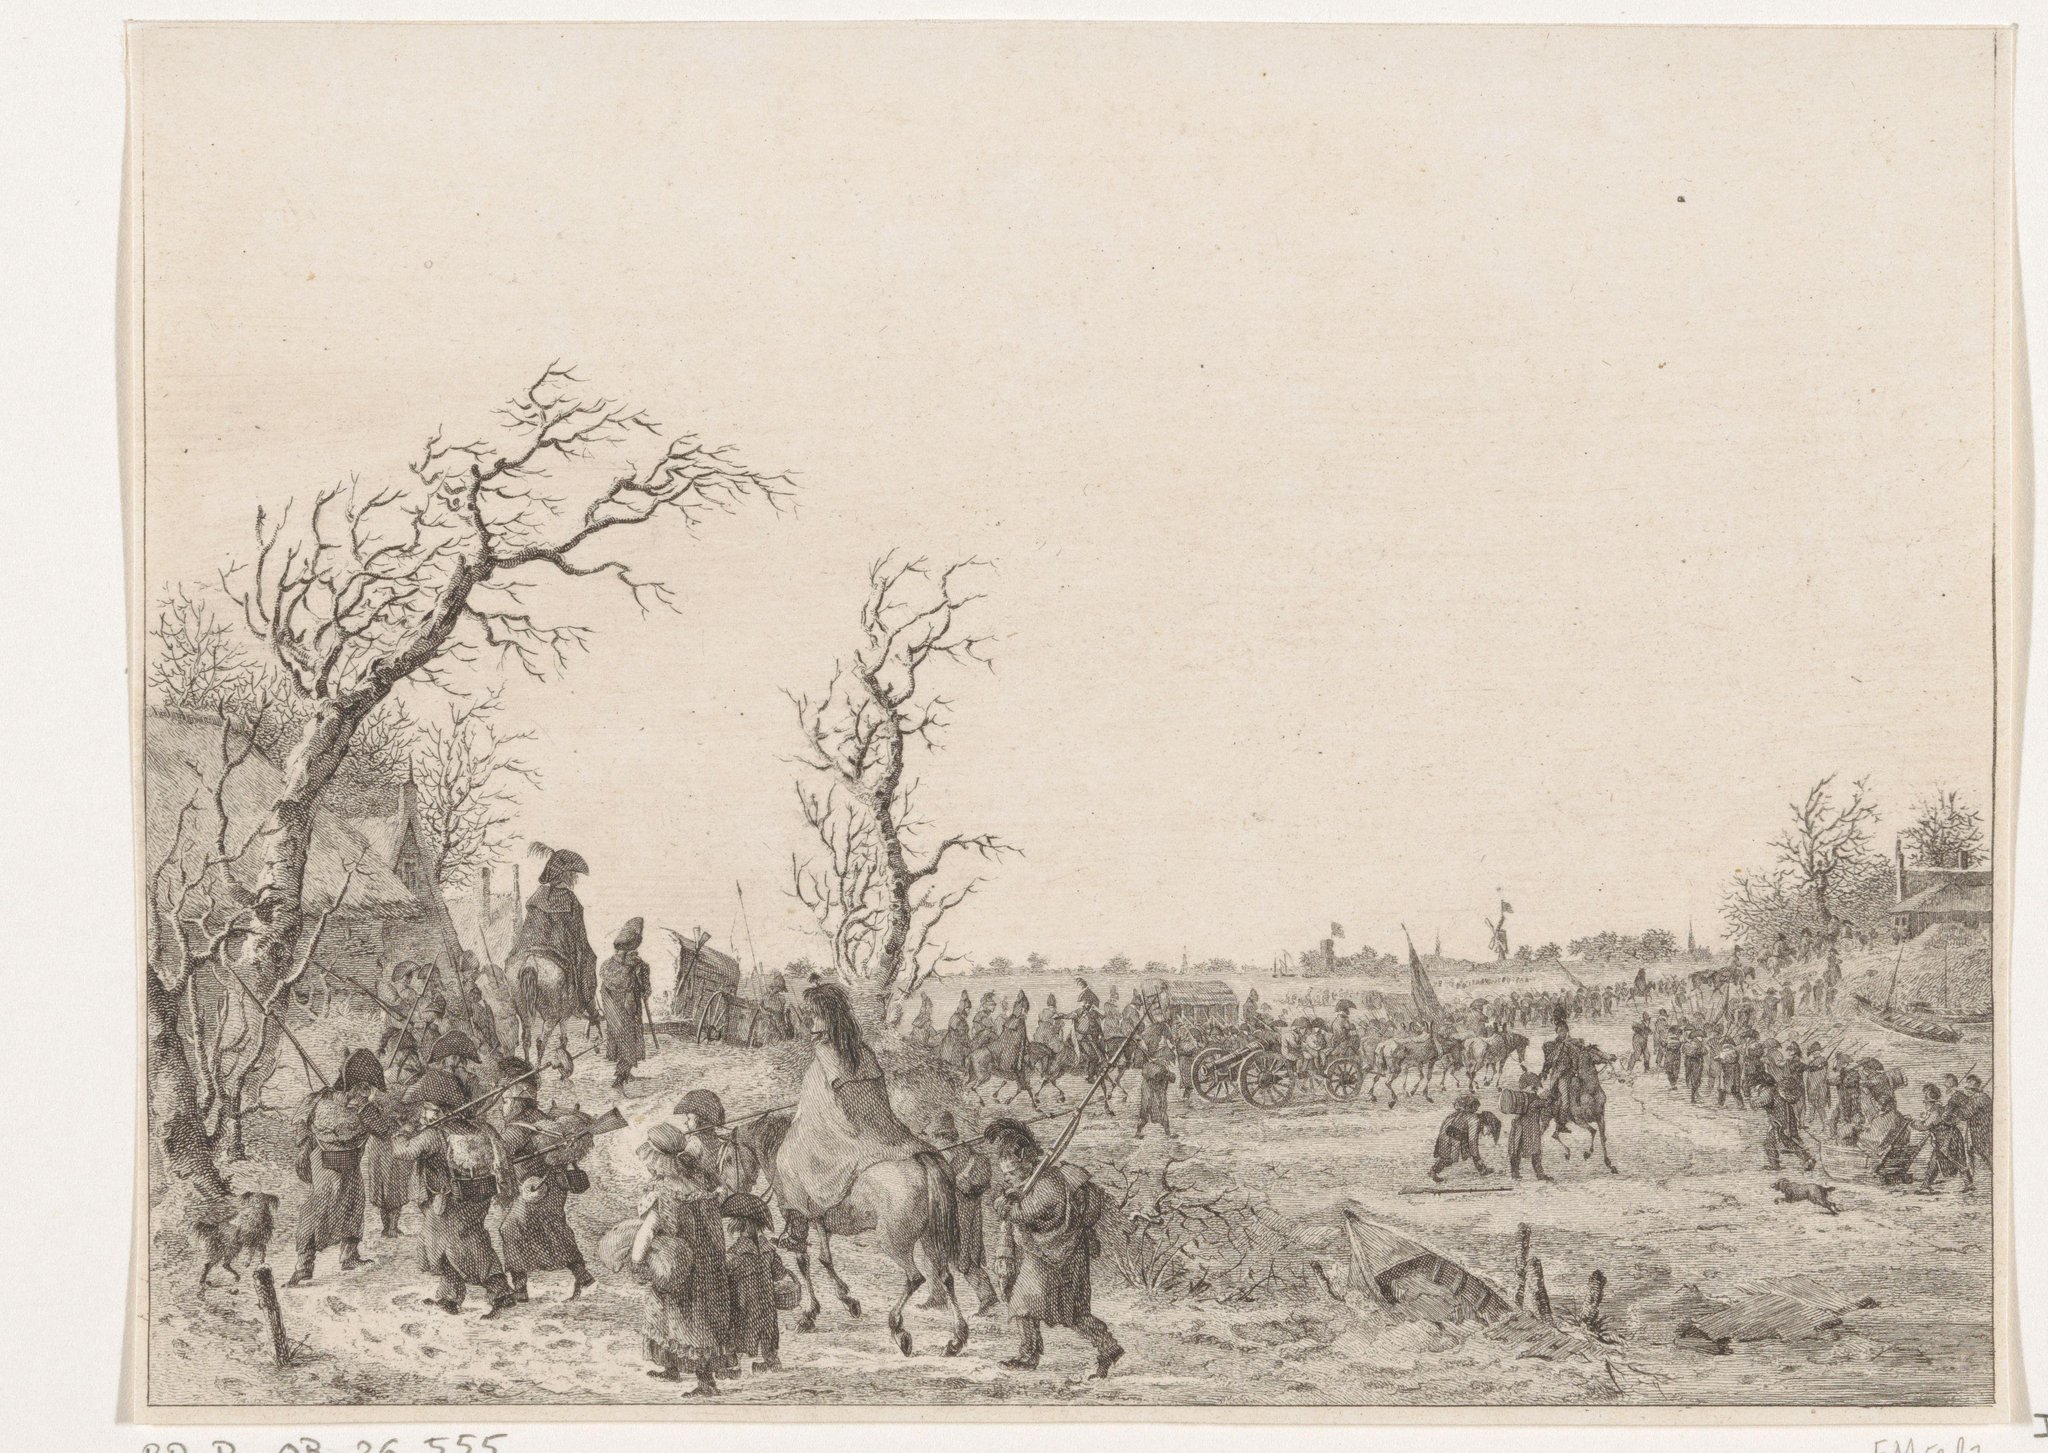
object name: print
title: Overtocht van de Franse troepen over de Waal in januari 1795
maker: joannes bemme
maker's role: print maker, printer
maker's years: 1775-1841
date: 1795-1841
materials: paper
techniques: etching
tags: jean-charles pichegru, the defeated (after the battle), march into the conquered place, transport, train (military) (+ land forces)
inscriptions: collector's mark: Lugt 2228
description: De gehavende soldaten steken te voet en te paard de bevroren rivier over. Geschut wordt op wagens mee gevoerd.